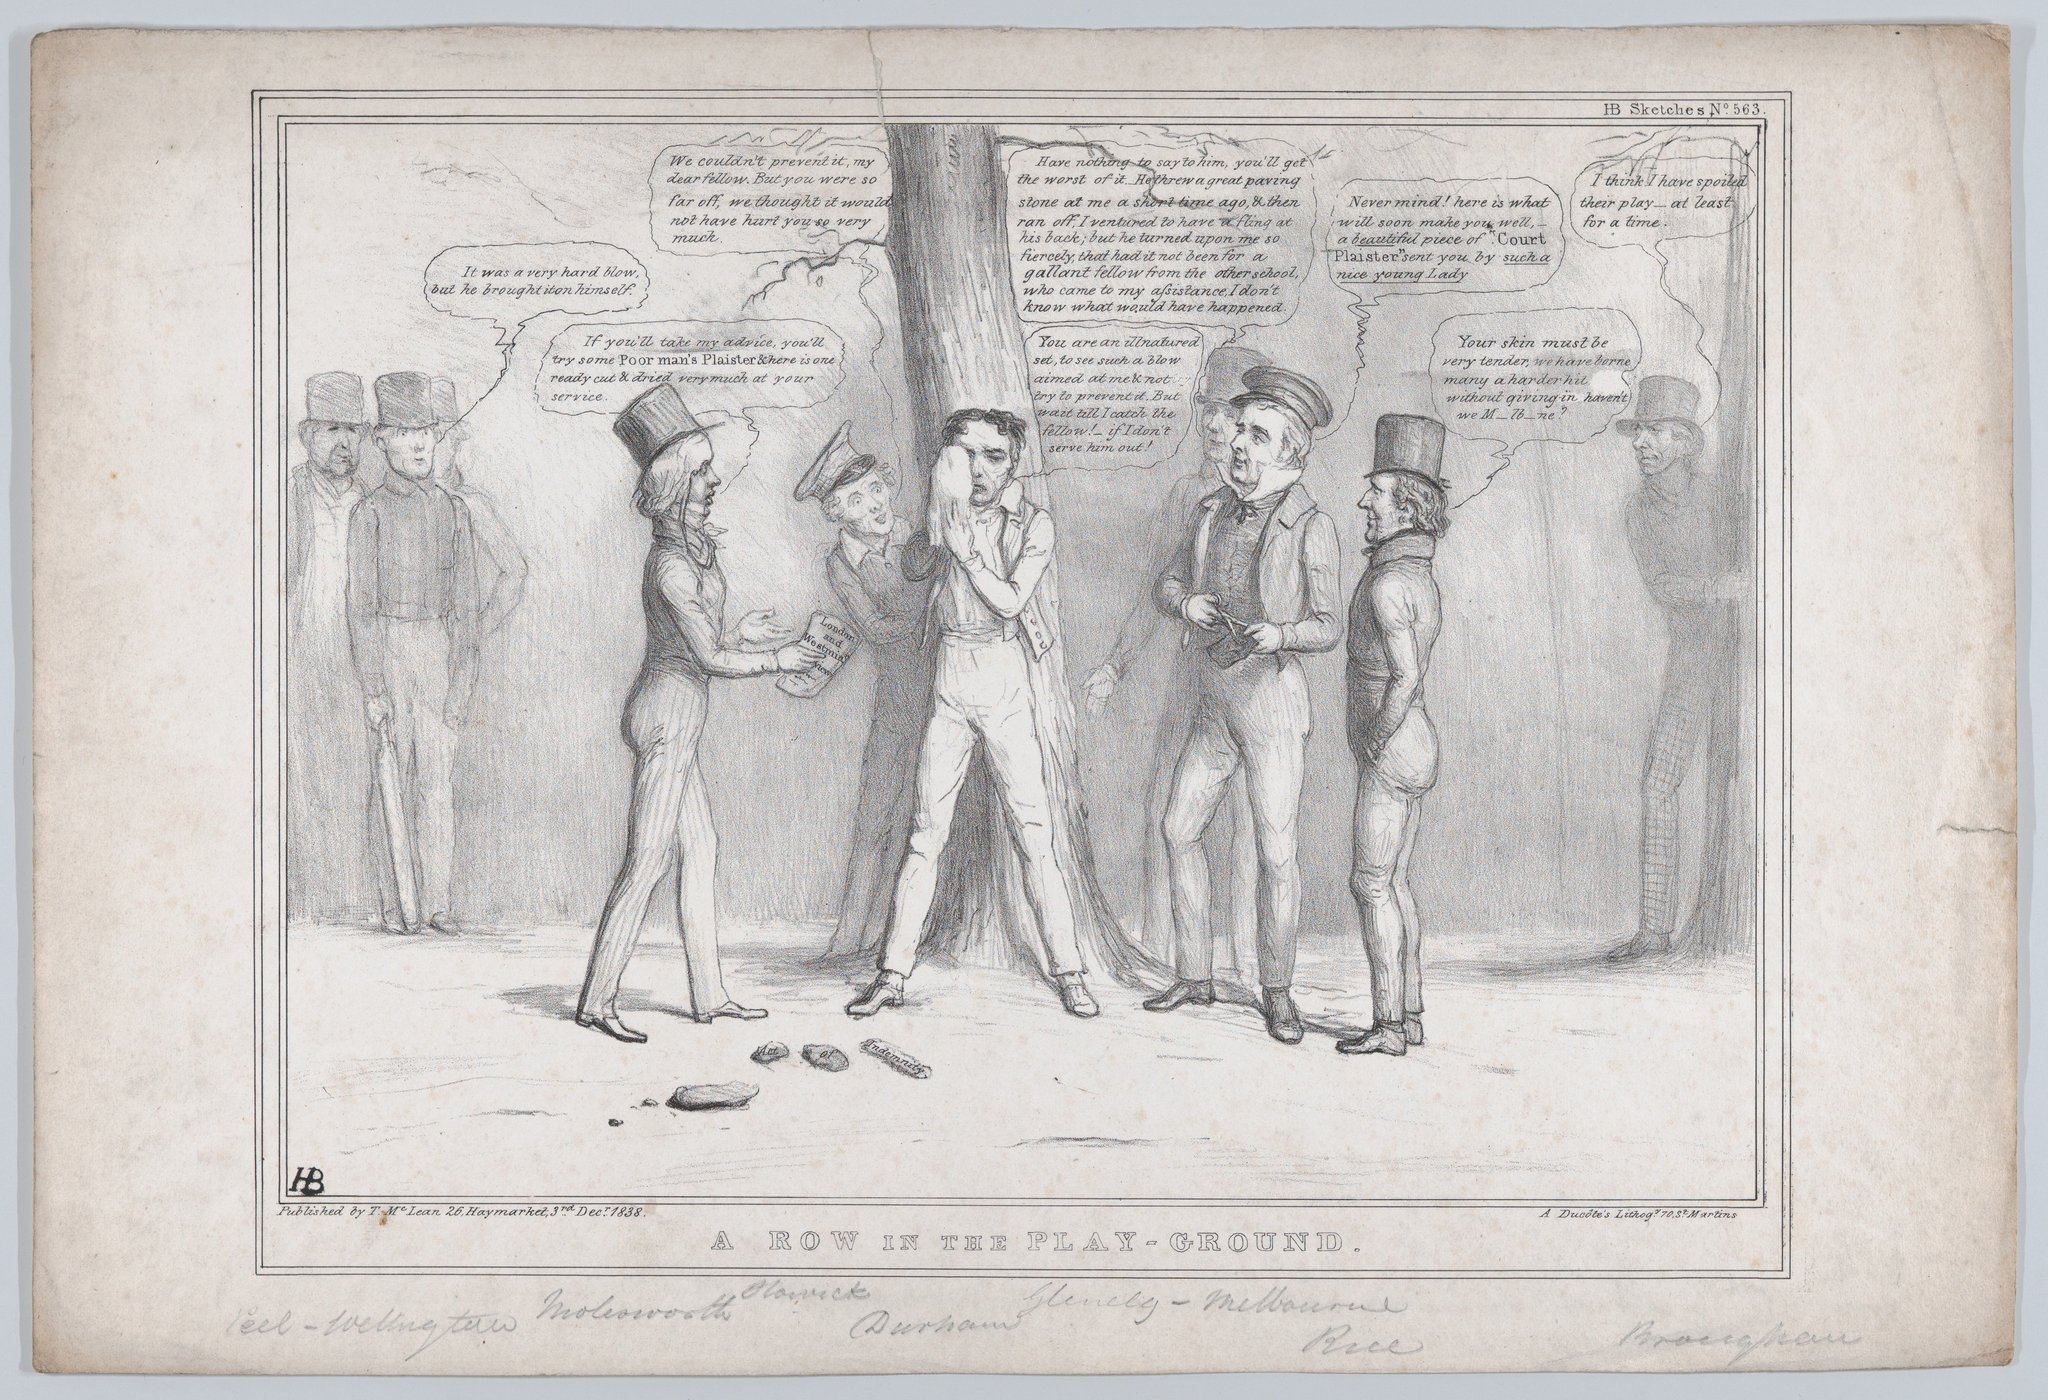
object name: print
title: A Row in the Play-Ground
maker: john doyle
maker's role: artist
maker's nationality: irish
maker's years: 1797-1868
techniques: lithograph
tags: men